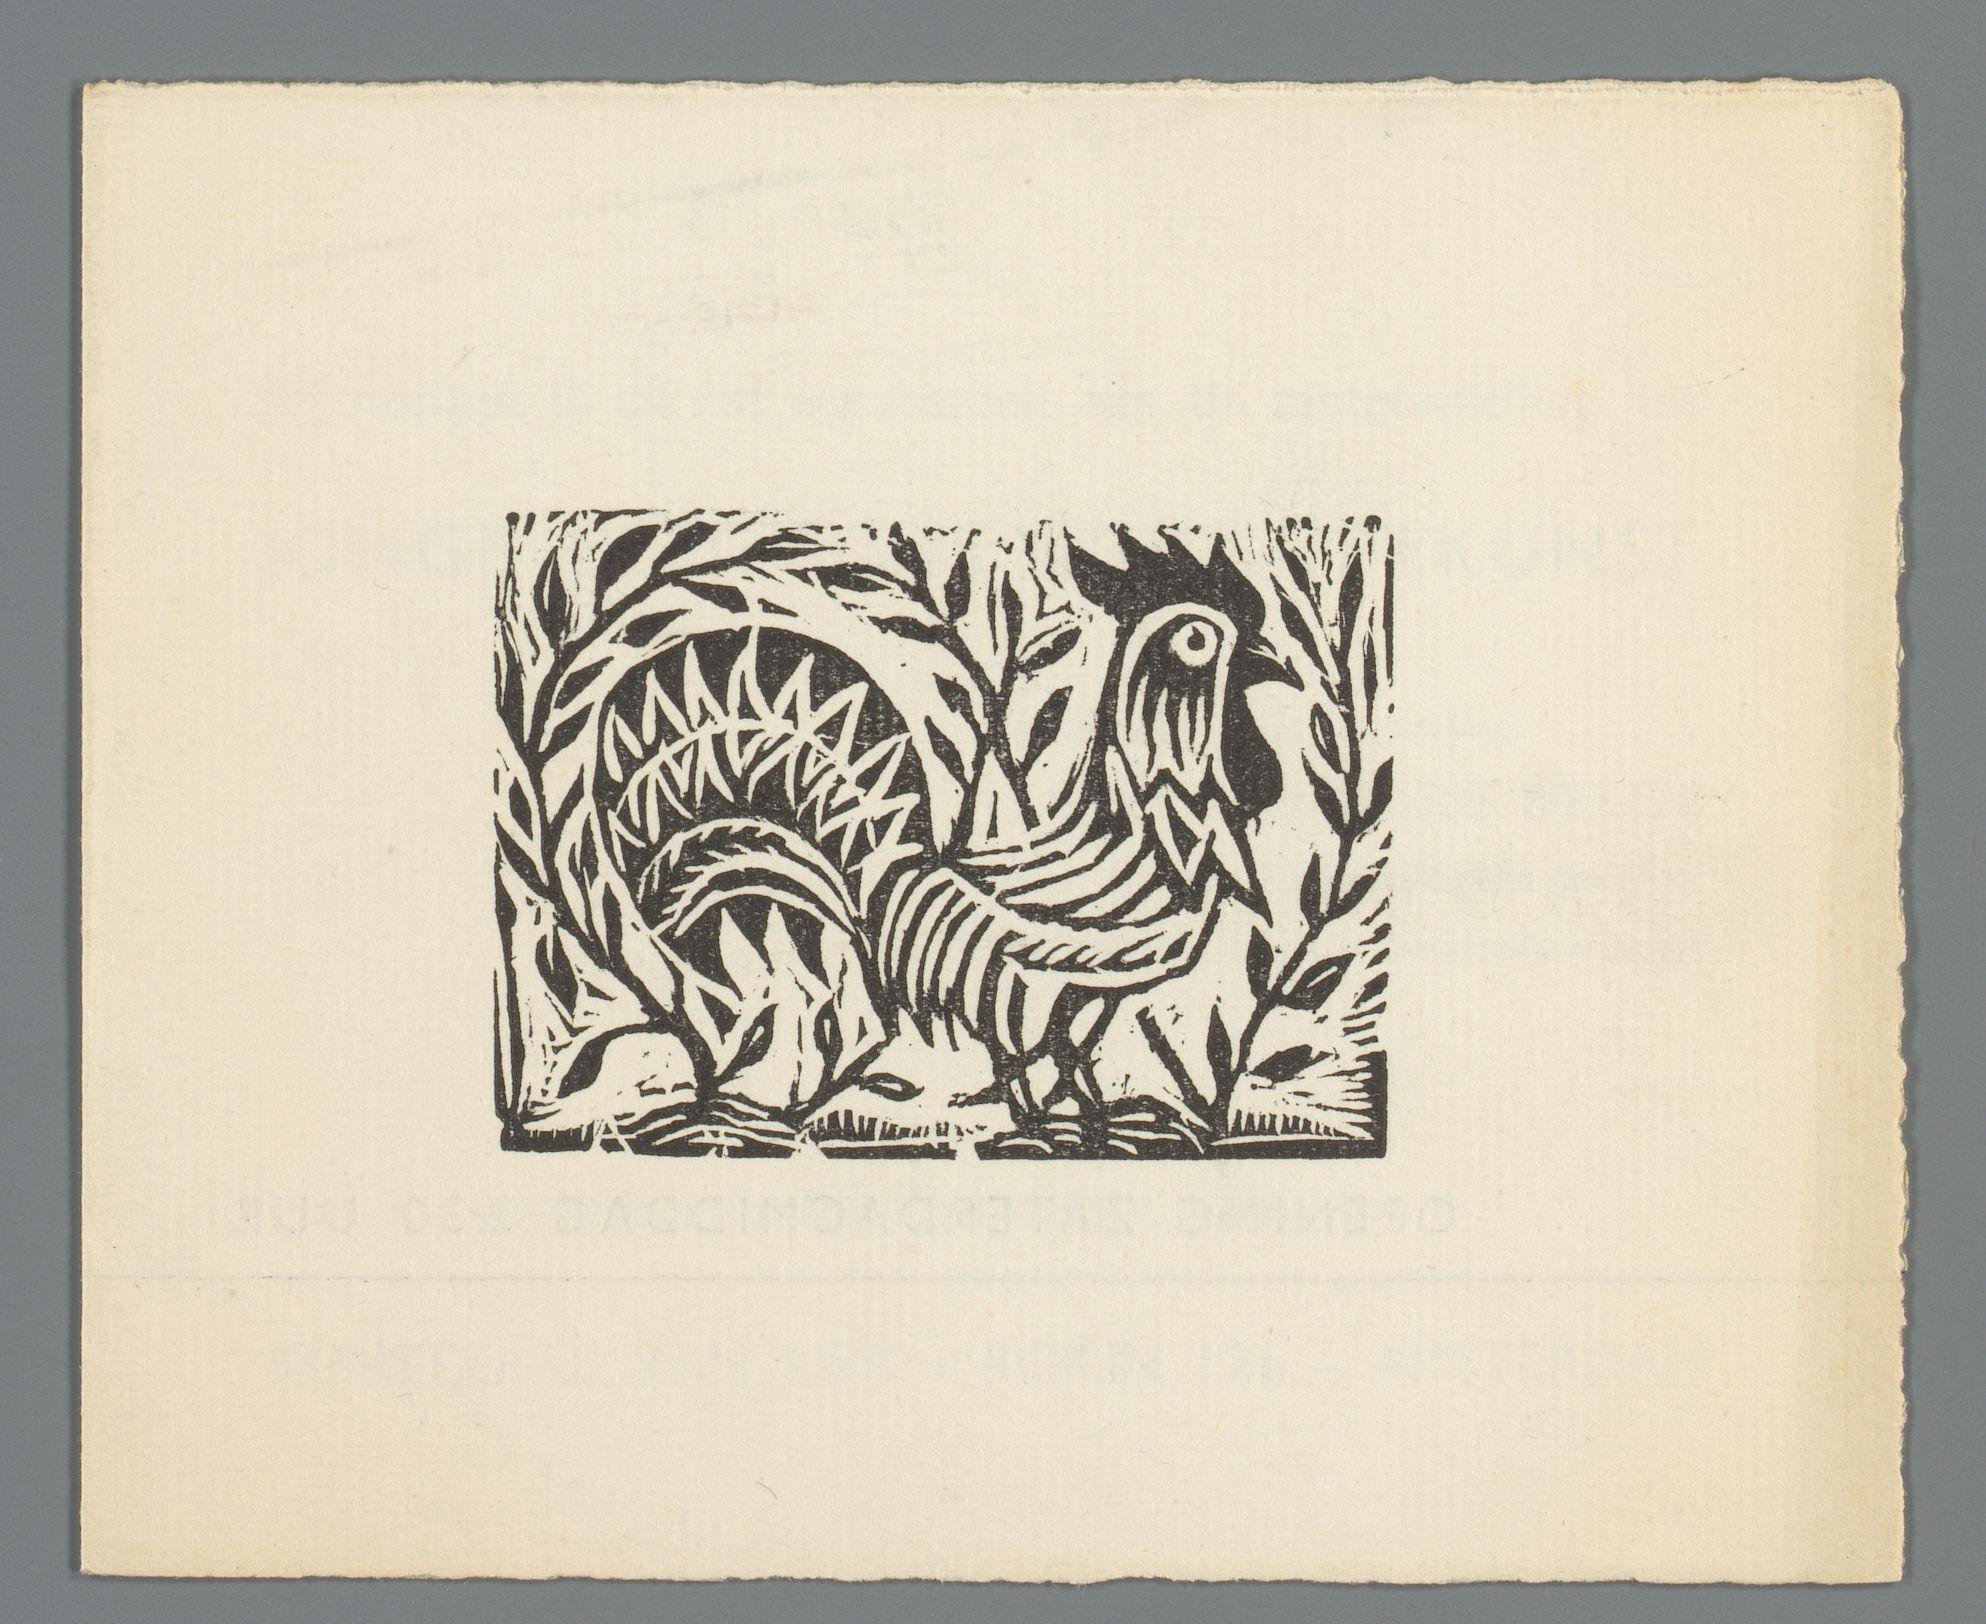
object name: invitation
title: Uitnodiging voor de tentoonstelling 'Jonge Belgische schilderkunst'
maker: Anonymous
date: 1946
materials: paper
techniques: letterpress printing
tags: fowl (cock, hen, chicken, etc.), collection, exhibition, show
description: Op de voorzijde een haan. Binnenin de tekst van de uitnodiging voor de tentoonstelling, van 9 november tot 5 december 1946 in Kunstzaal van Lier, Amsterdam. Deze tentoonstelling werd georganiseerd door de vereniging 'Jeune peinture Belge' (De Jonge Belgische Schilderkunst).